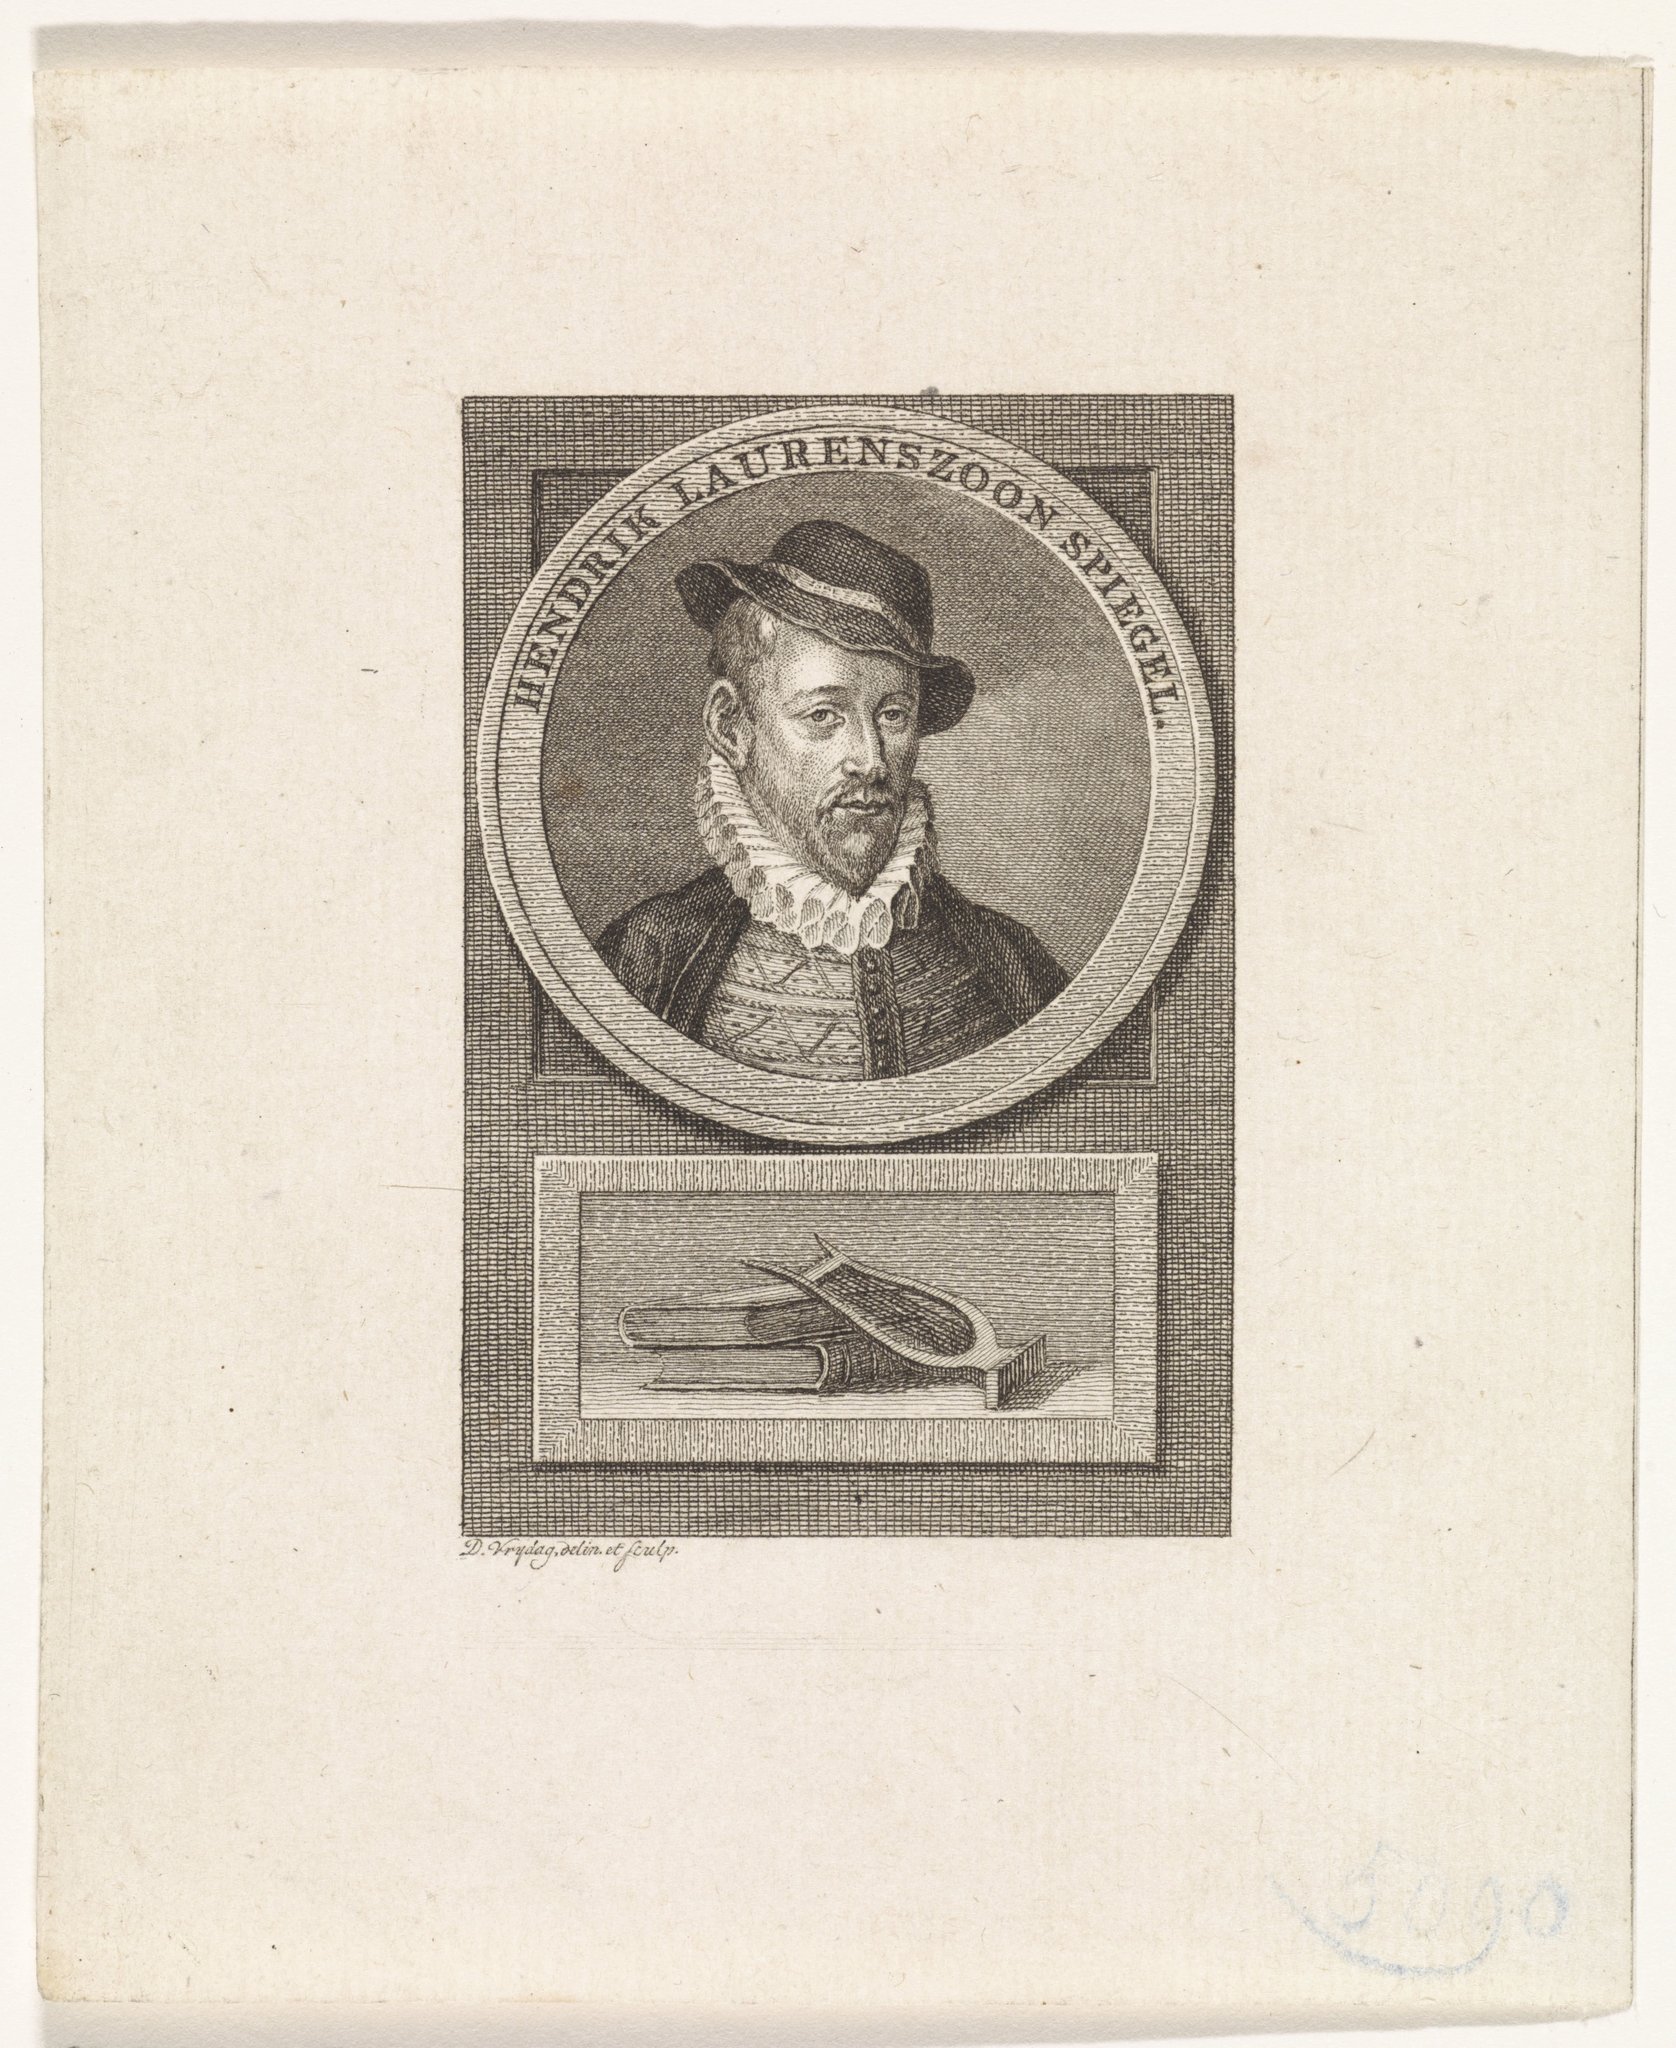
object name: print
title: Portret van dichter Hendrick Laurensz. Spieghel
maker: daniël vrijdag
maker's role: draughtsman, print maker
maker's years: 1765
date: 1780-1822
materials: paper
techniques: etching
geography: netherlands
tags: amsterdam, hendrick laurensz. spieghel, lyre, cithara, psaltery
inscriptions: collector's mark: Lugt 2228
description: In het kader onder zijn portret boeken en een lier.